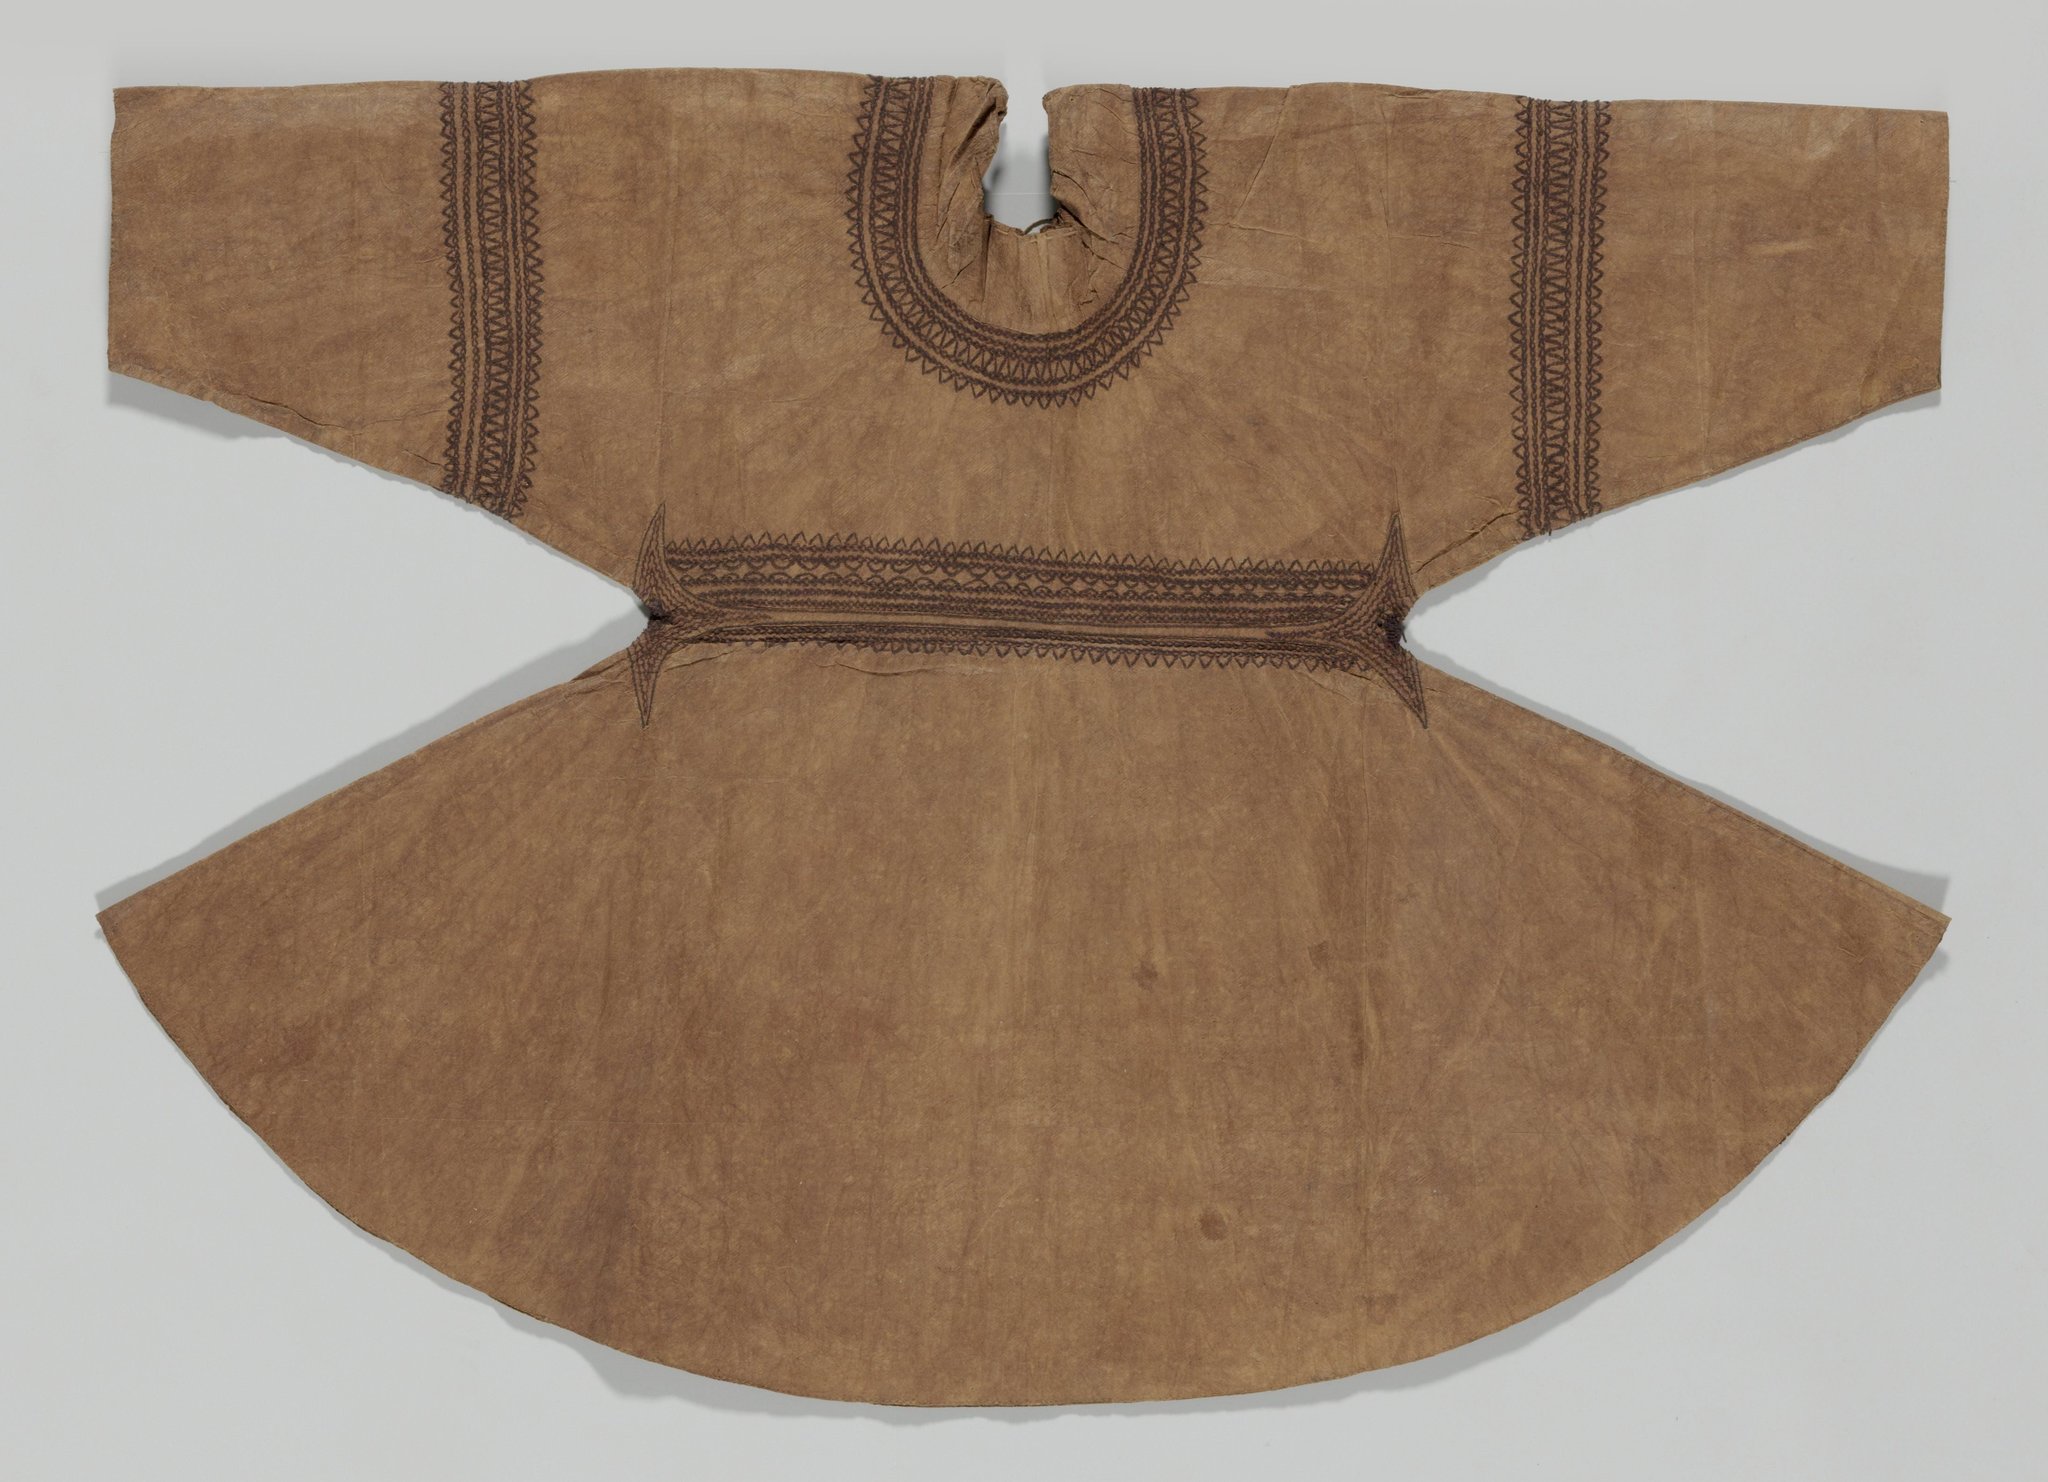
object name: coat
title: Blouse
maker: Anonymous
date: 1900-1949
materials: fiber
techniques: embroidered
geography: toraja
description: Bark cloth is made in the same way as paper. Tree bark is soaked in water and the wet substance is then beaten and pressed to extract the moisture. The resulting cloth is both soft and strong. The bottom of this traditional women’s blouse from Sulawesi is wide, to make room for a voluminous skirt underneath.